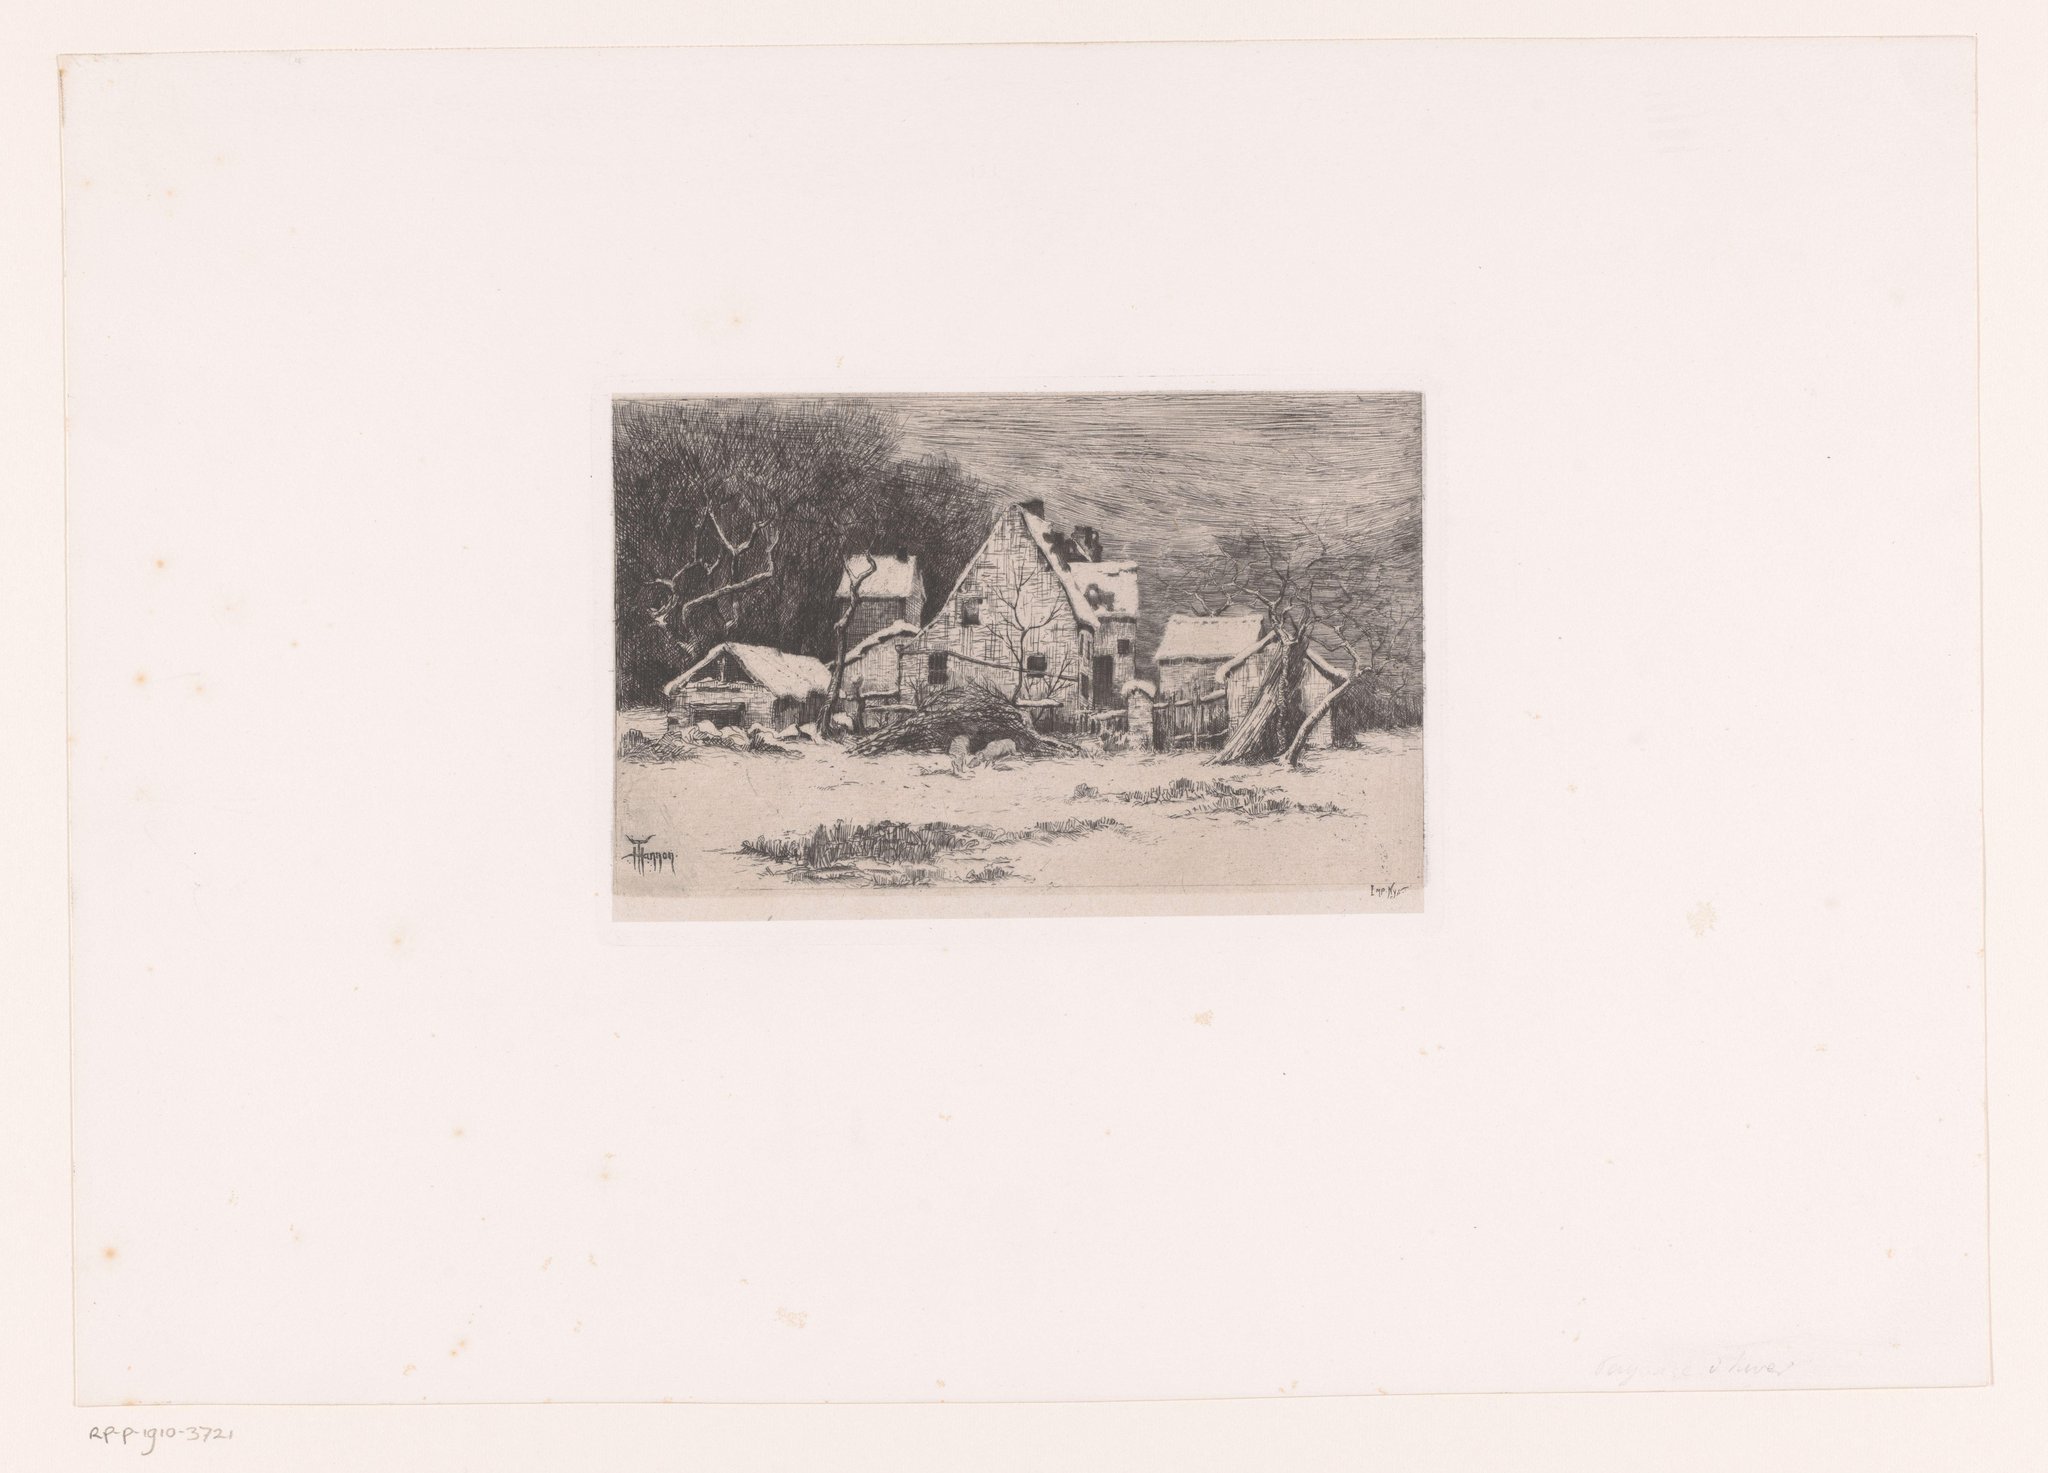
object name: print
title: Wintergezicht met boerderij met twee varkens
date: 1861-1910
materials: paper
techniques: etching, intaglio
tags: pig, farm or solitary house in landscape, farm (building)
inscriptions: collector's mark: Lugt 2228